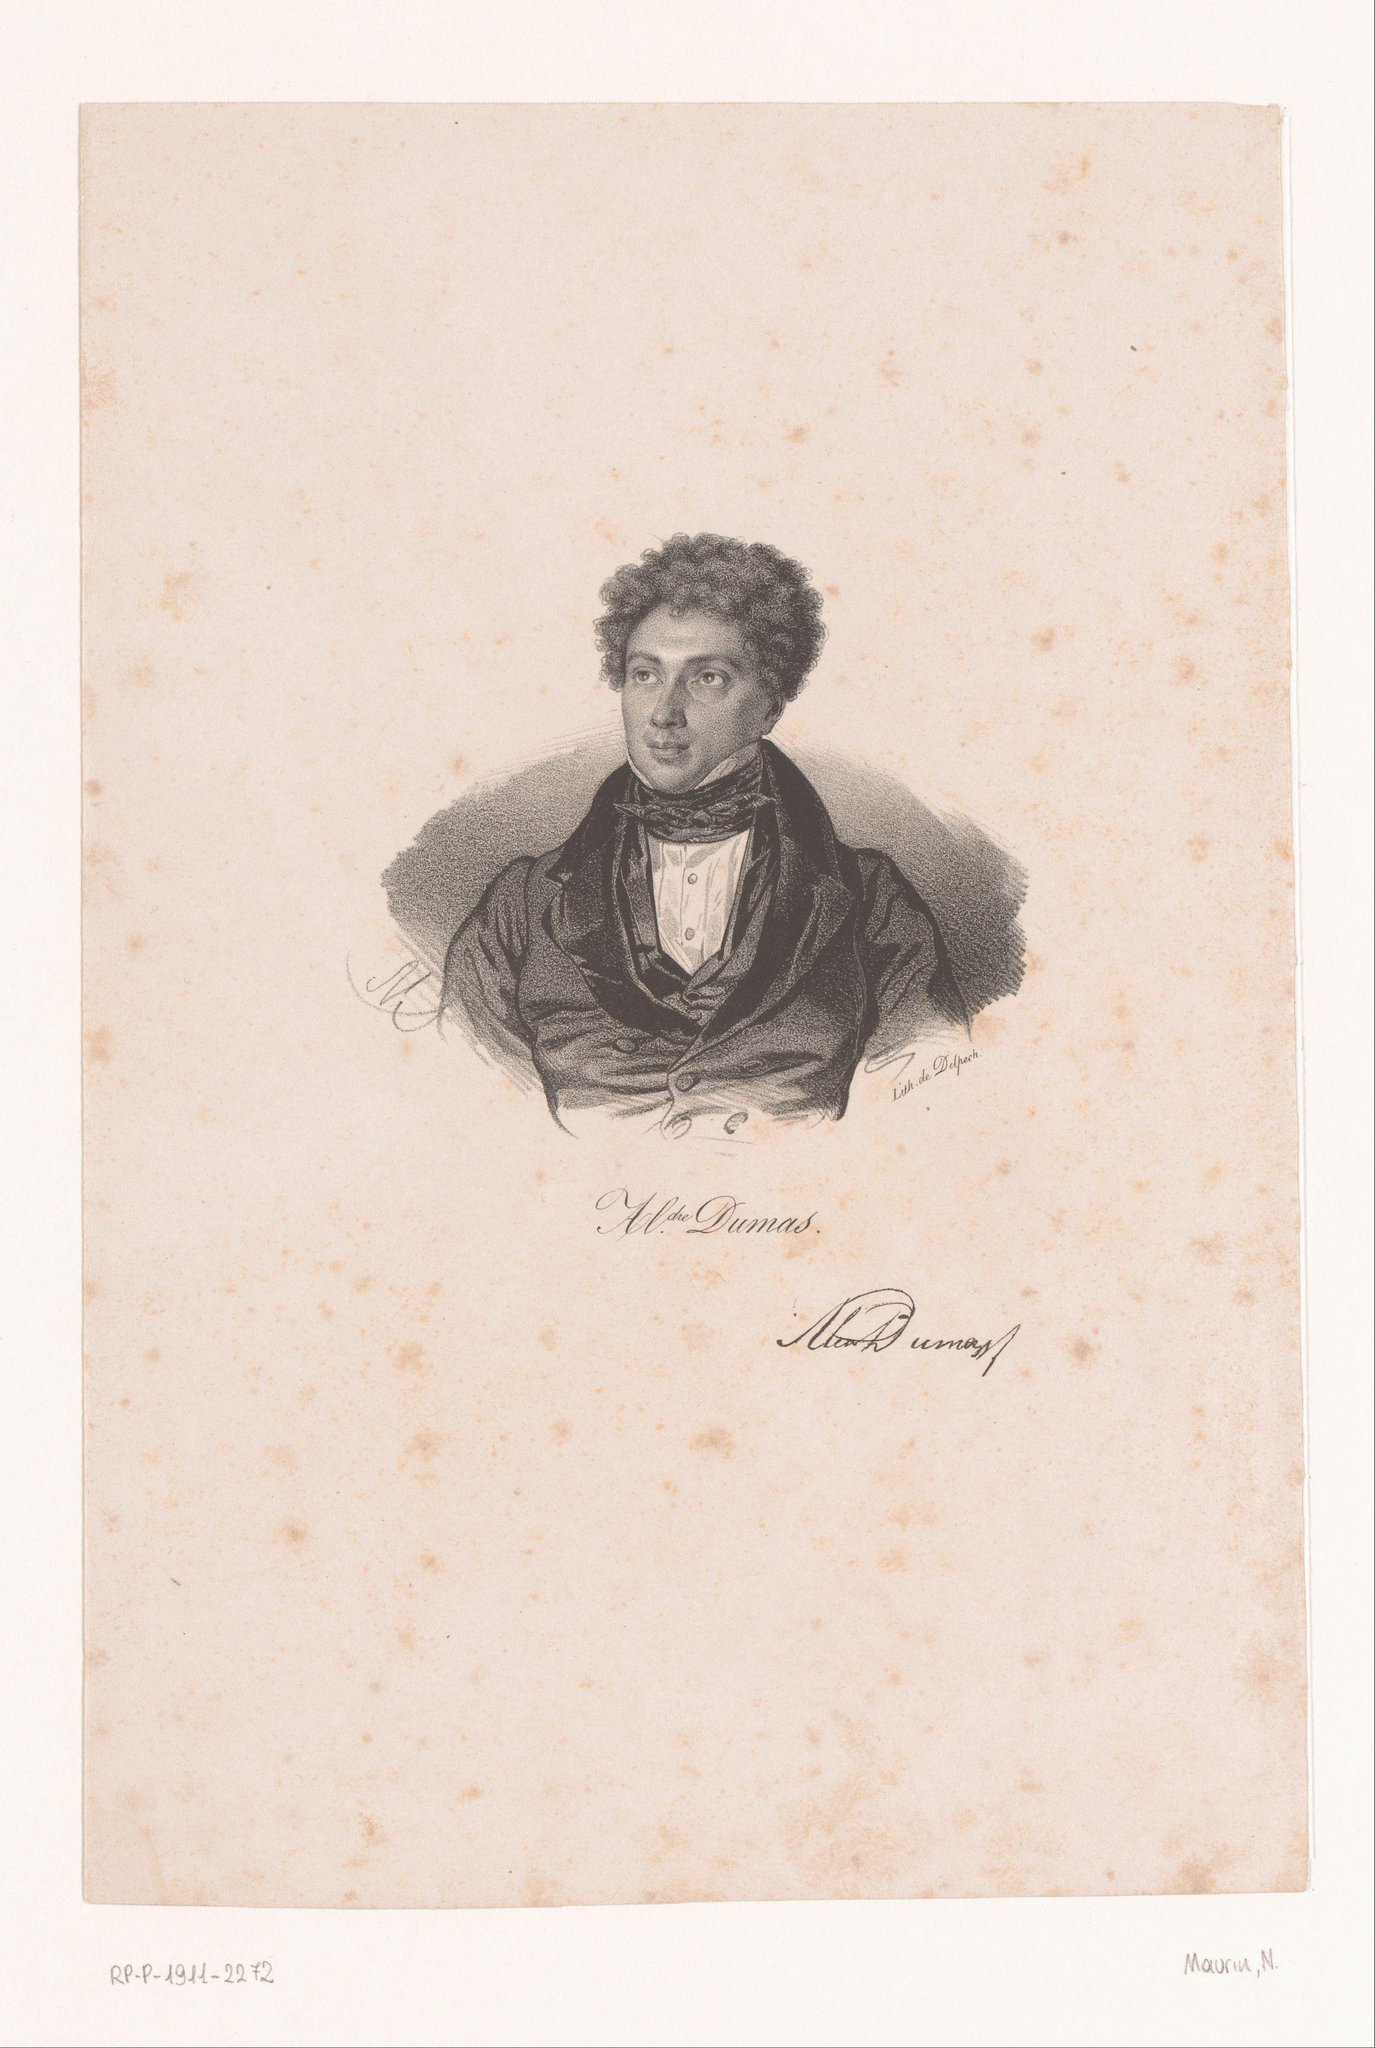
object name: print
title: Portret van Alexandre Dumas père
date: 1834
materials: paper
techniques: lithograph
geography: paris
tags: historical persons, writer, poet, author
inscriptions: collector's mark: Lugt 2228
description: Prent waarschijnlijk gebruikt voor: Célébrités contemporaines ou portraits des personnes de notre époque (…). Parijs: veuve Delpech, 1842. En/of voor: Célébrités contemporaines ou portraits des personnes de notre époque (…). Parijs: Rosselin, 1845-1849. Mogelijk komt de prent ook voor in eerdere en/of latere publicaties uitgegeven door veuve Delpech of haar opvolger Rosselin.